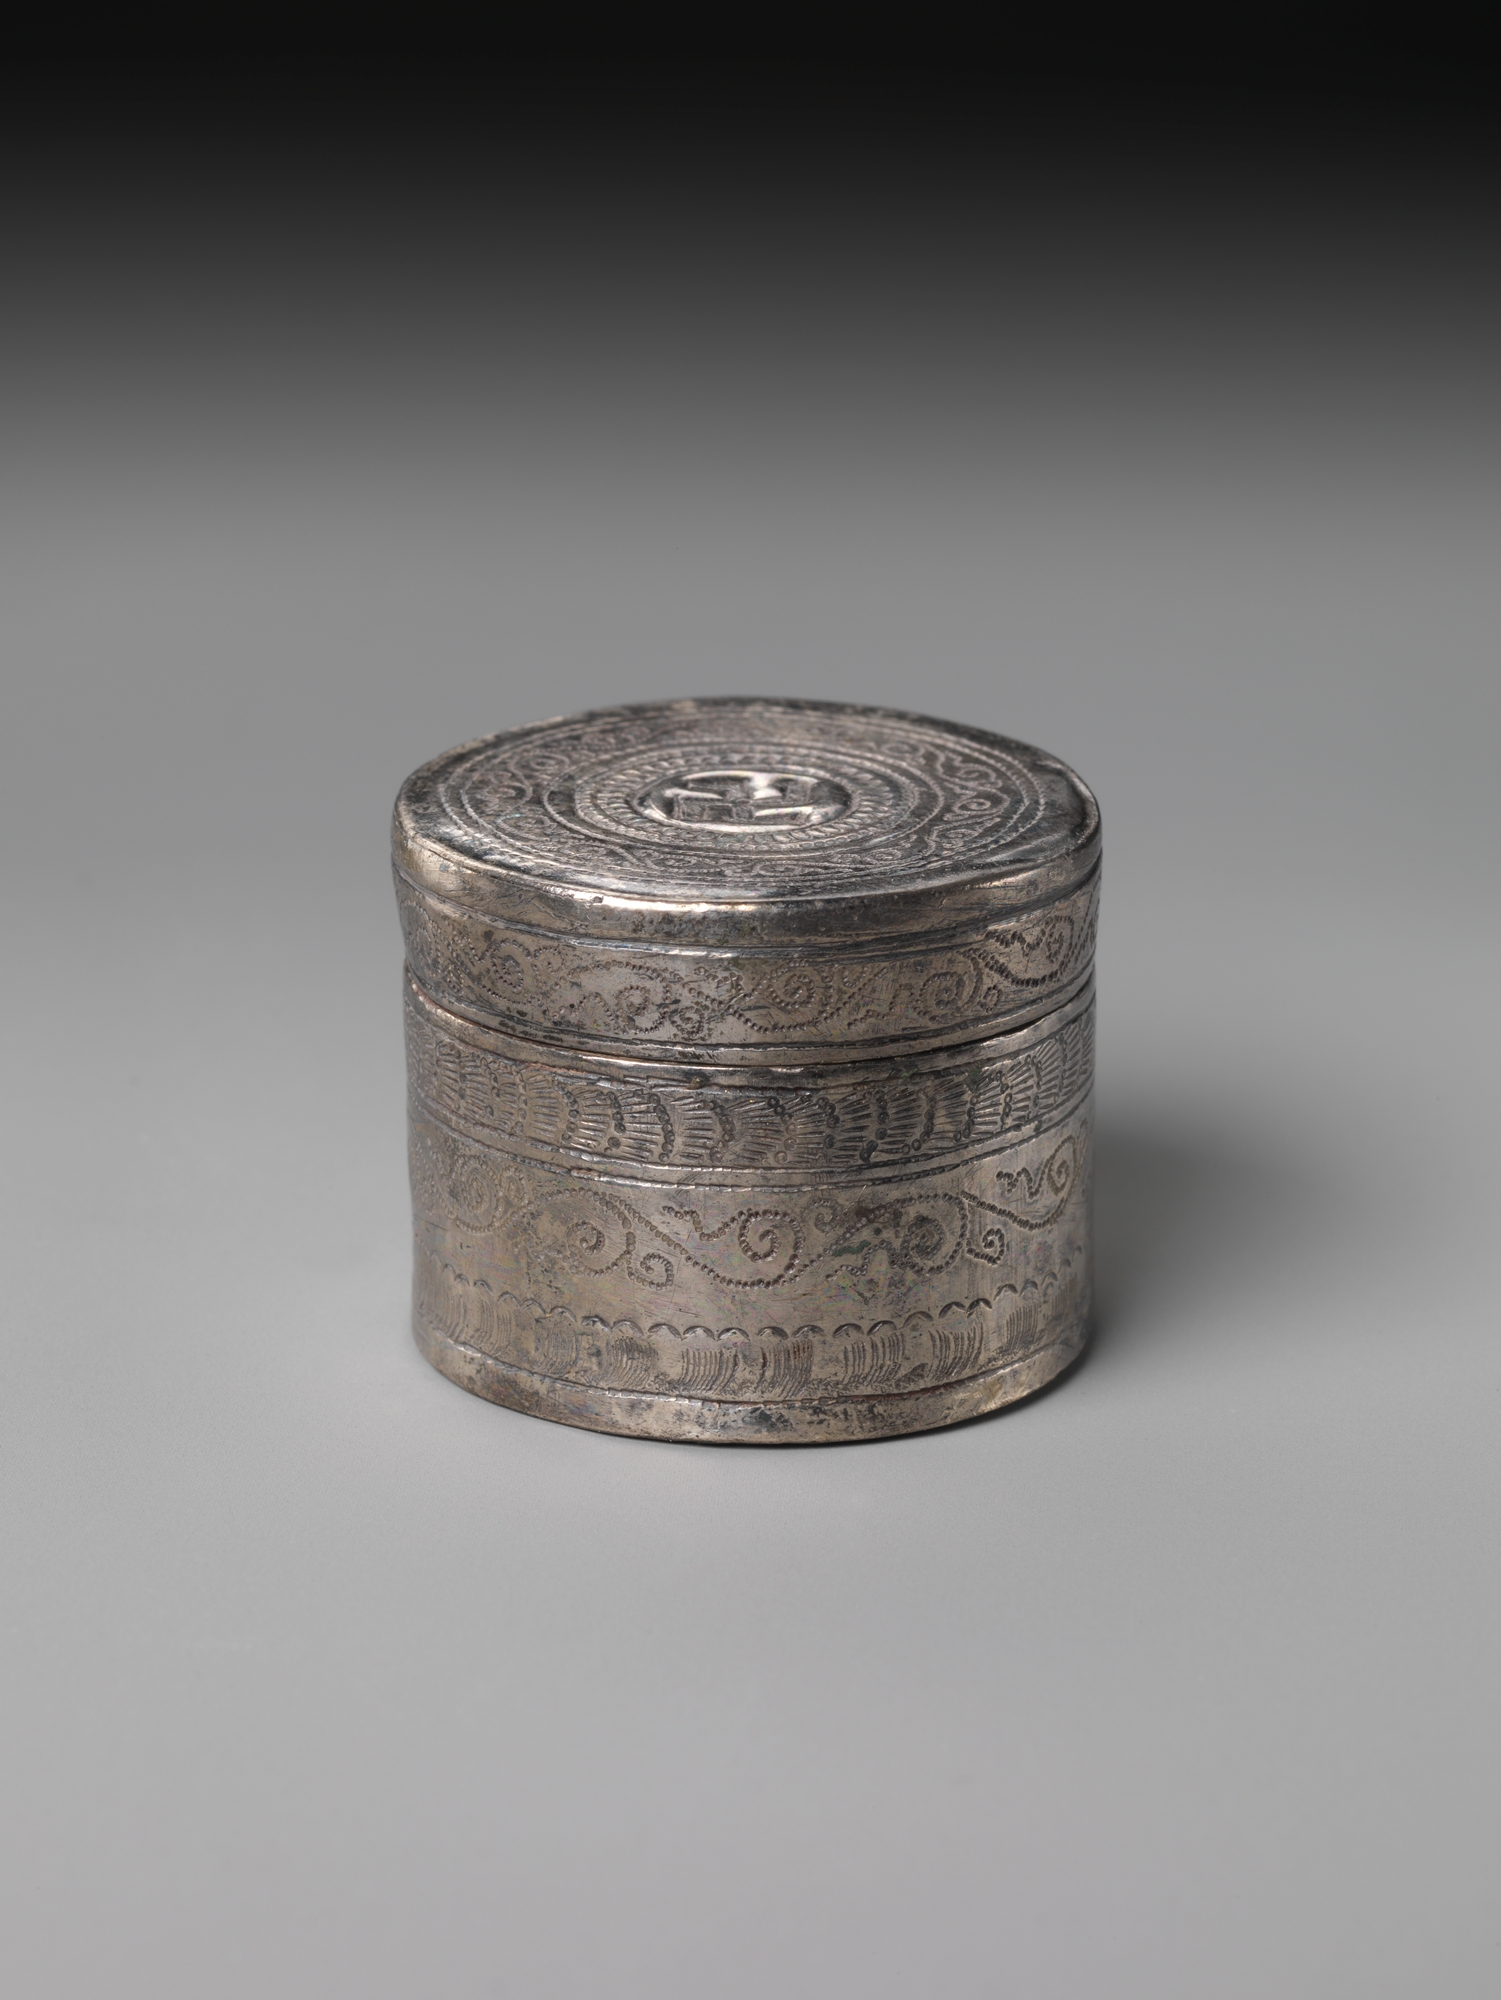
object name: covered box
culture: korean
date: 918-1392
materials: silver